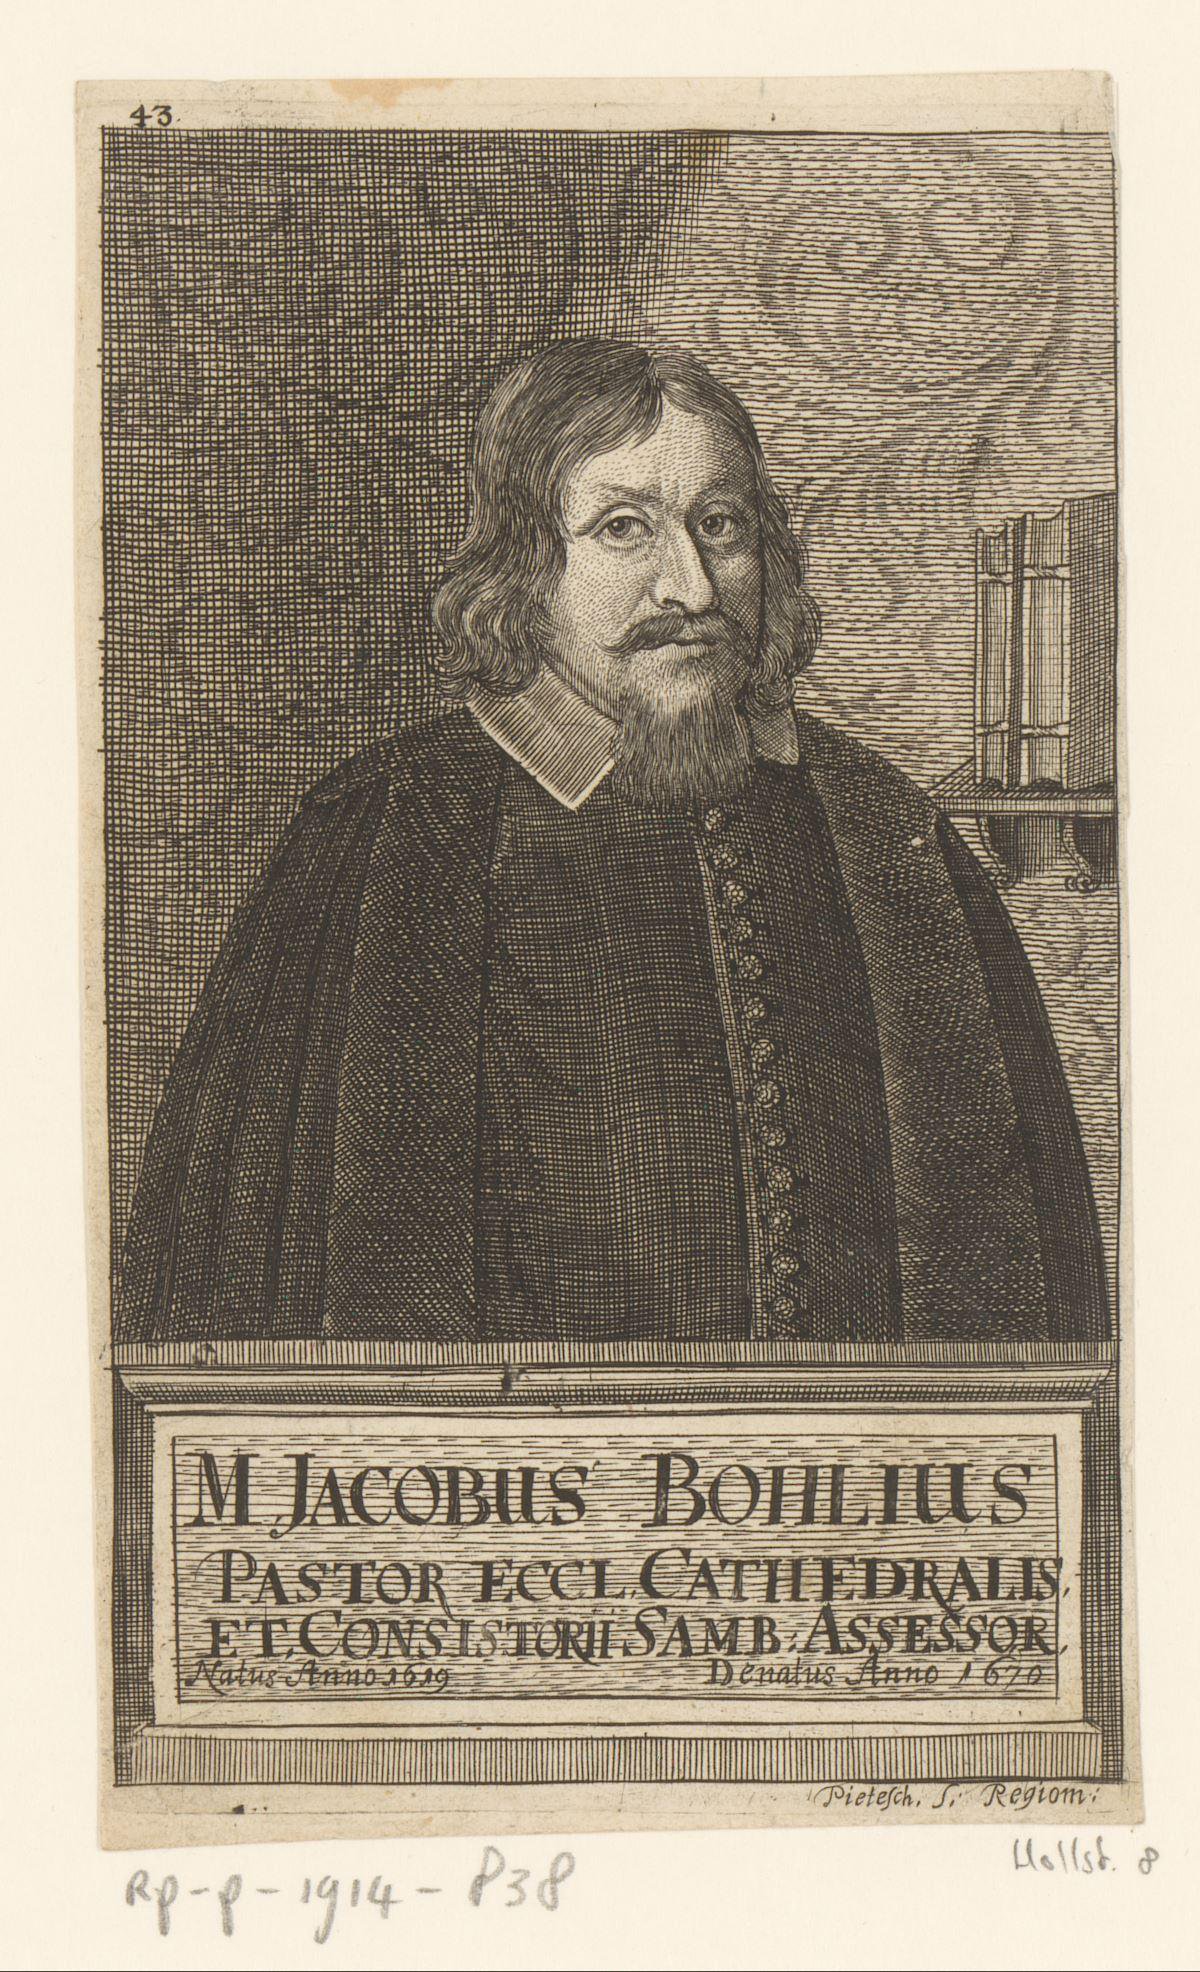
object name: print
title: Portret van Jacob Bohle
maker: christian daniel pietesch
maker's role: print maker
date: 1670-1700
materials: paper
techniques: engraving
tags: historical persons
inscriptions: collector's mark: Lugt 2228